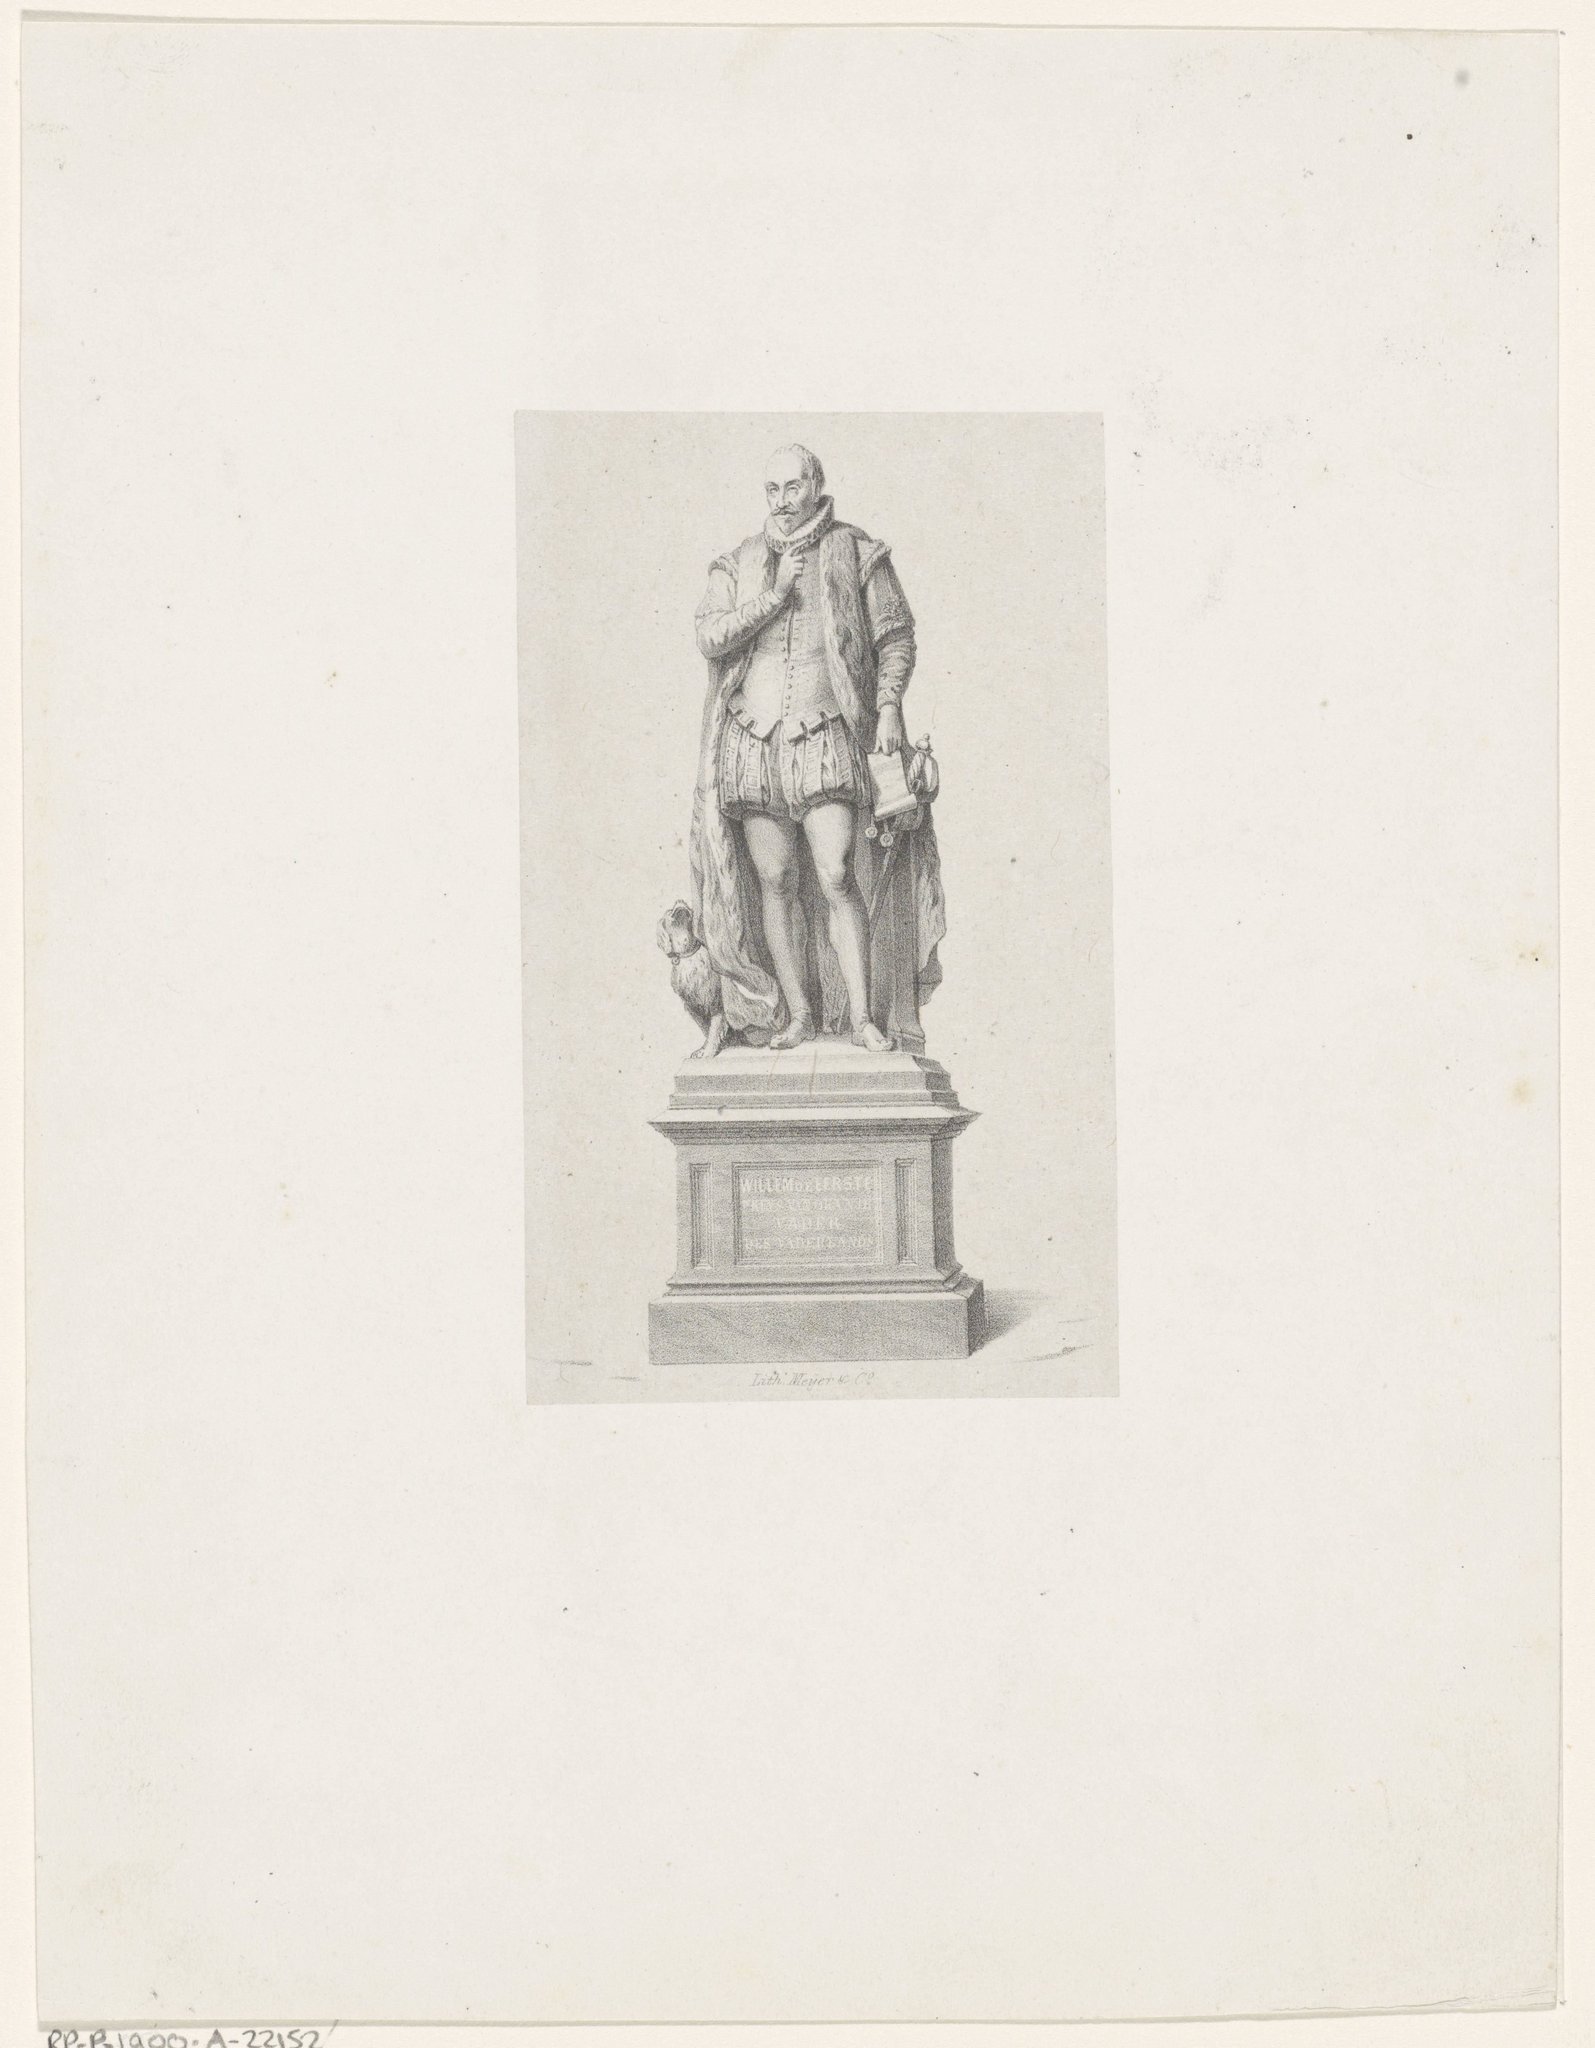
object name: print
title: Standbeeld van Willem I, prins van Oranje, op het Plein te Den Haag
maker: Anonymous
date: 1848-1899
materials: paper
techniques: lithograph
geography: netherlands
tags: william i (prince of orange), monument, statue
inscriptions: collector's mark: Lugt 2228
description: De hier vermelde titel verwijst naar de hoogst verkregen titel van de geportretteerde, niet per se naar de titel die de geportretteerde op deze voorstelling draagt.